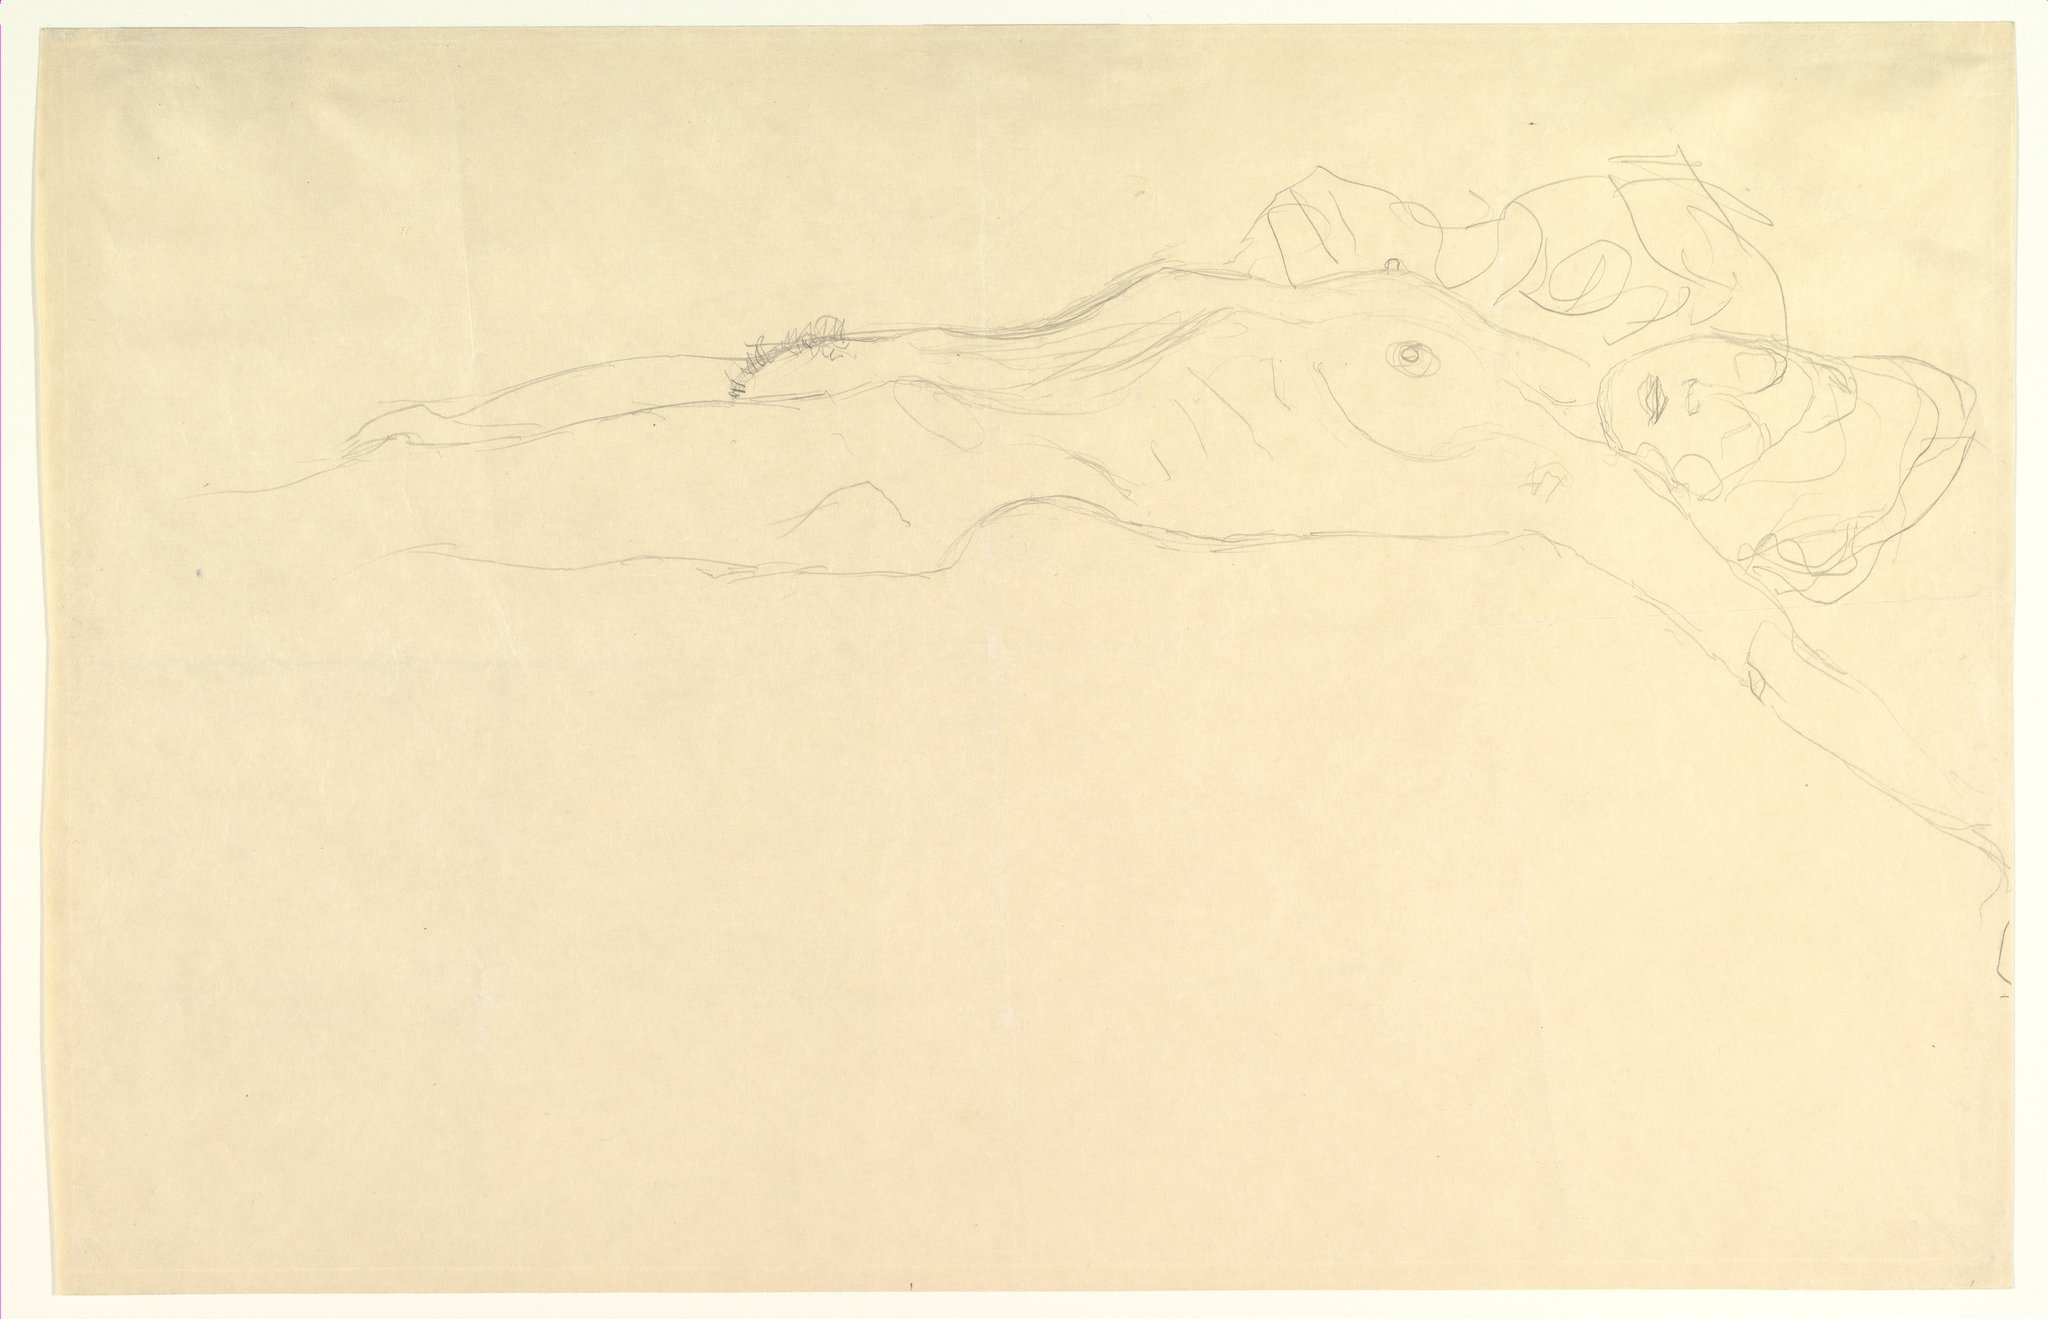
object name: drawing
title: Reclining Nude with Outstretched Left Arm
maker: gustav klimt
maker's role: artist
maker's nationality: austrian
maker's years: 1862-1918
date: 1903-1904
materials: graphite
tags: female nudes